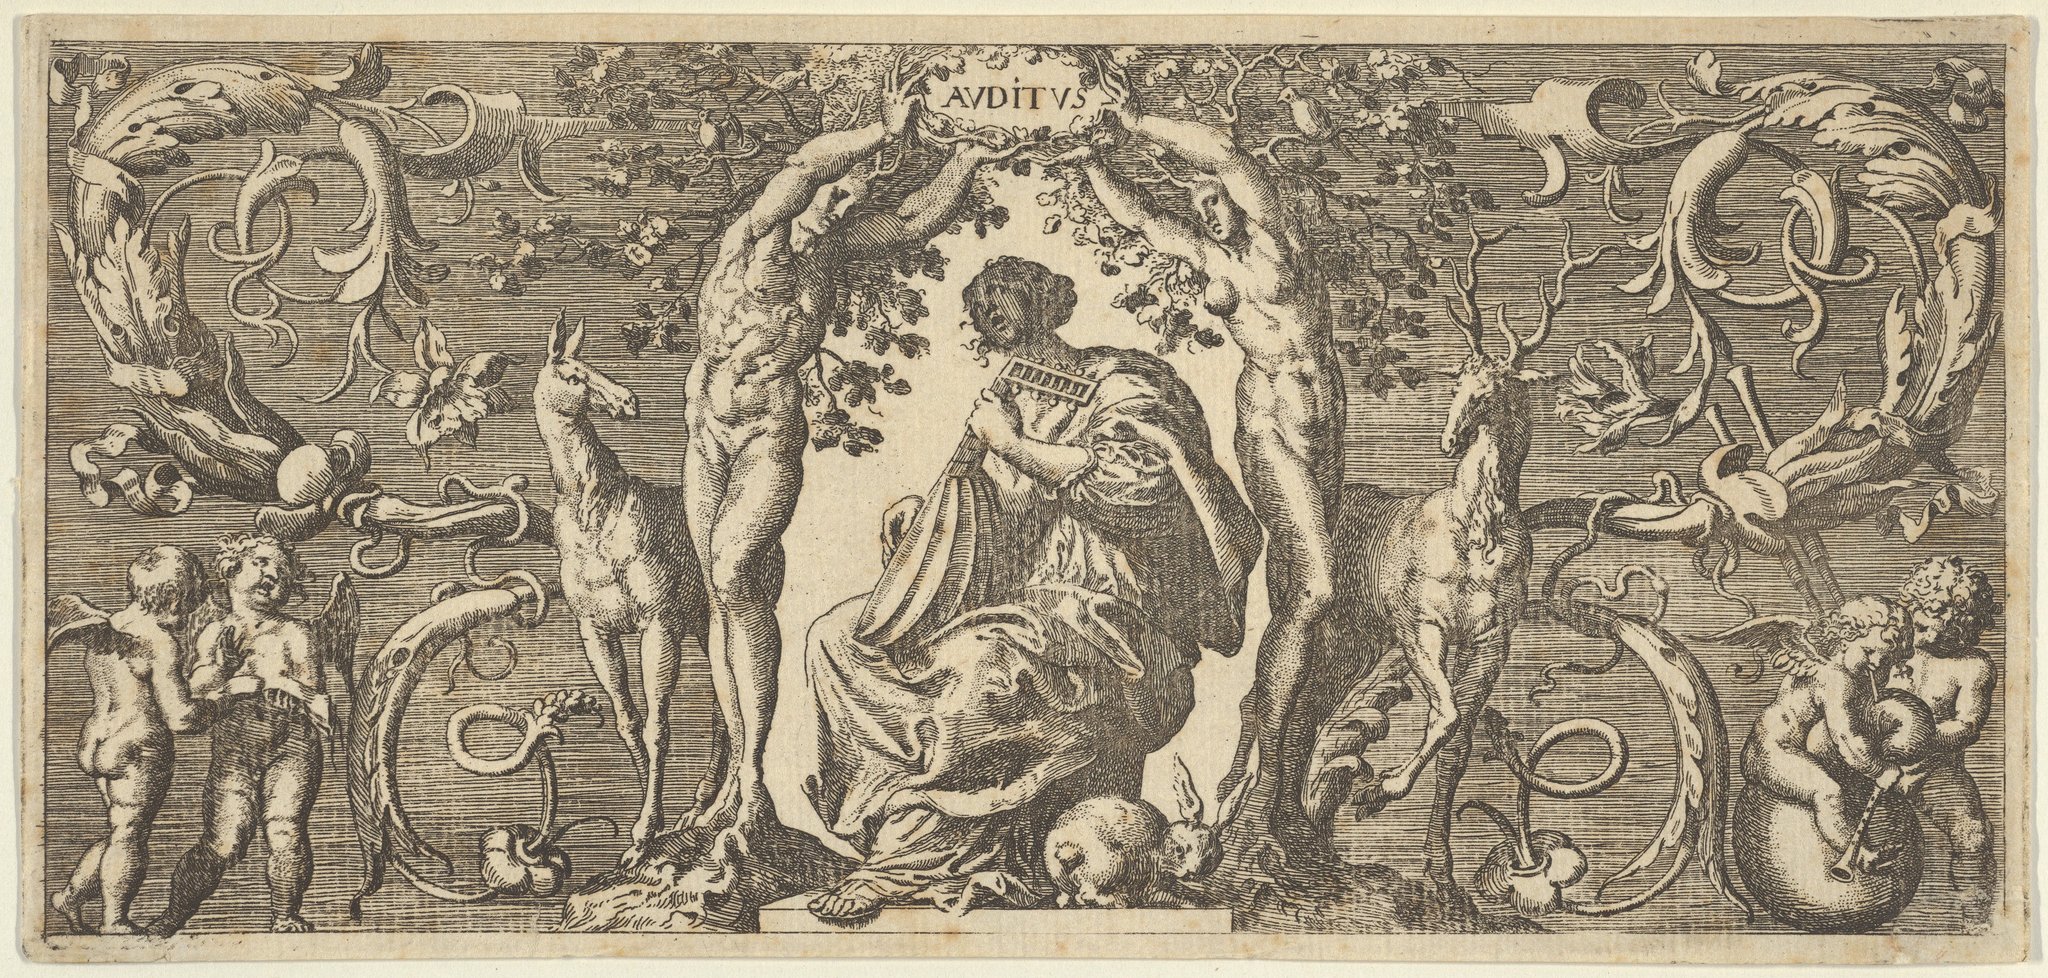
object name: print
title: Hearing (Auditus), from "Quinque Sensuum"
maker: franz cleyn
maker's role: artist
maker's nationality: german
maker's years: 1582-1658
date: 1655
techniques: engraving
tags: women,female nudes,bagpipes,lutes,deer